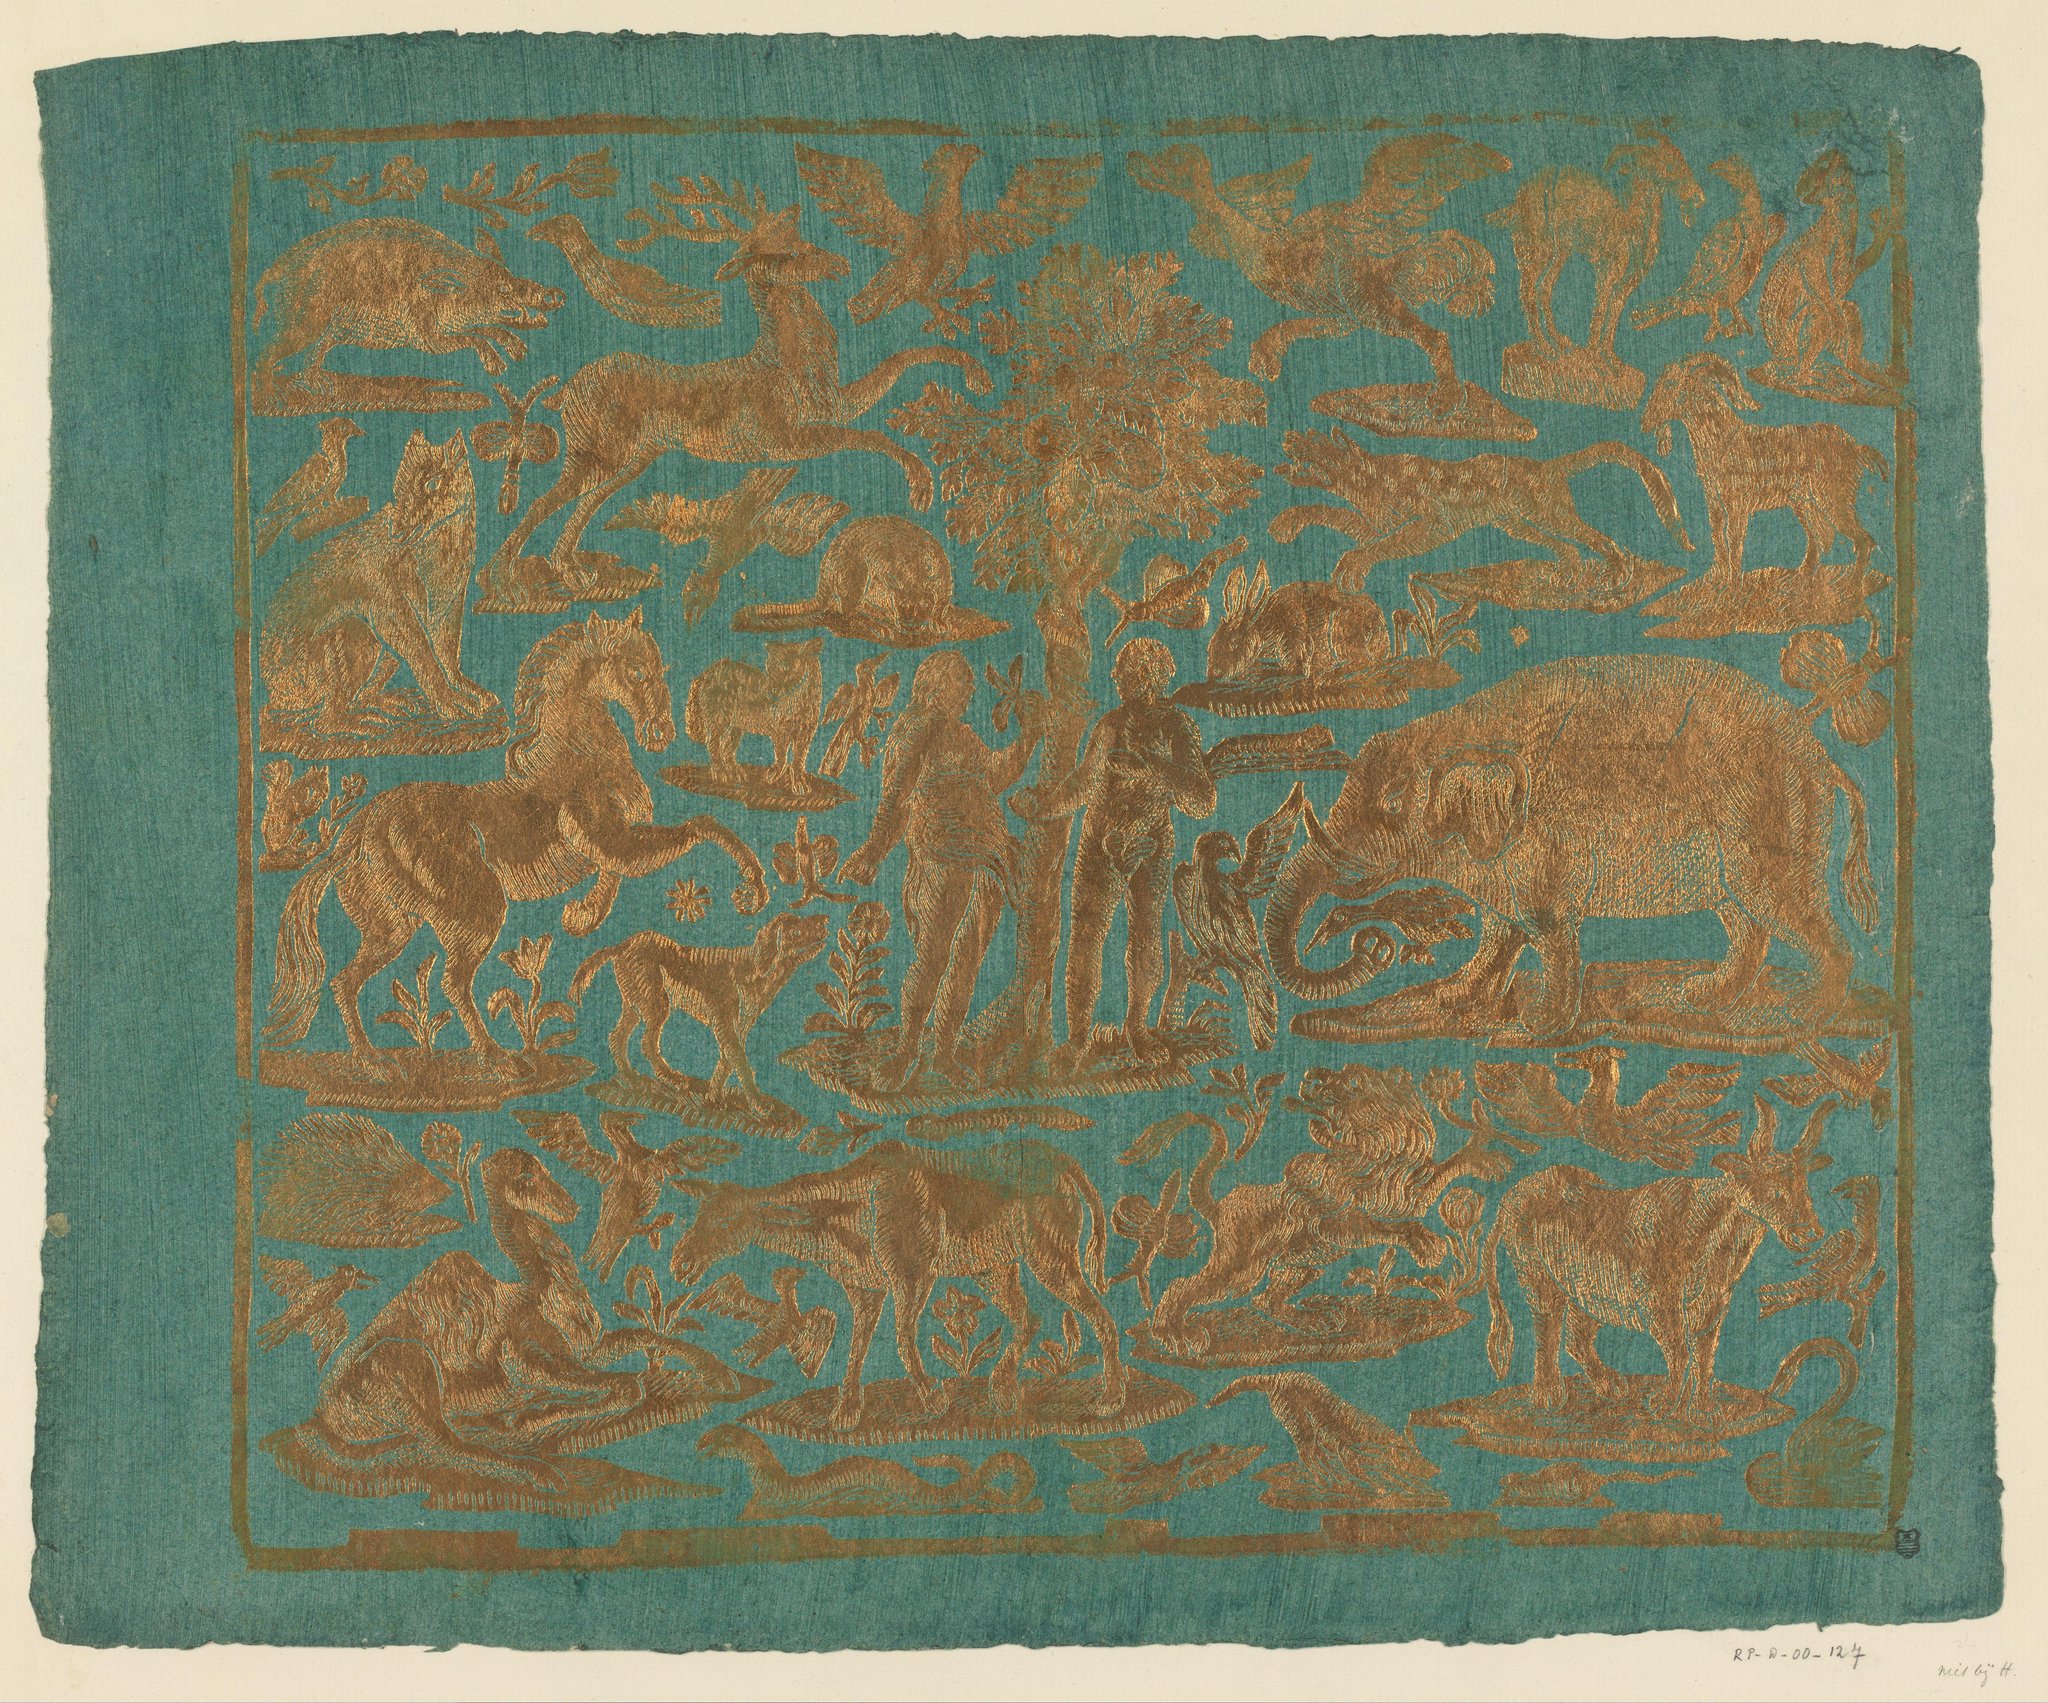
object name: wrapper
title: Blad met in het midden Adam en Eva onder de appelboom, omgeven door dieren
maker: marx leonhard kauffmann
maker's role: papiermaker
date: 1761-1772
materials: gold leaf, paint, paper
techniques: relief print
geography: augsburg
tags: eve offers the fruit to adam, animals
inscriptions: collector's mark: Lugt 2760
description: Op dit exemplaar is het adres en het nummer uitgewist. Naam van de uitgever (M.L. Kauffmann) en nummer (5) ontleend aan andere exemplaren waarop het adres nog intact is.